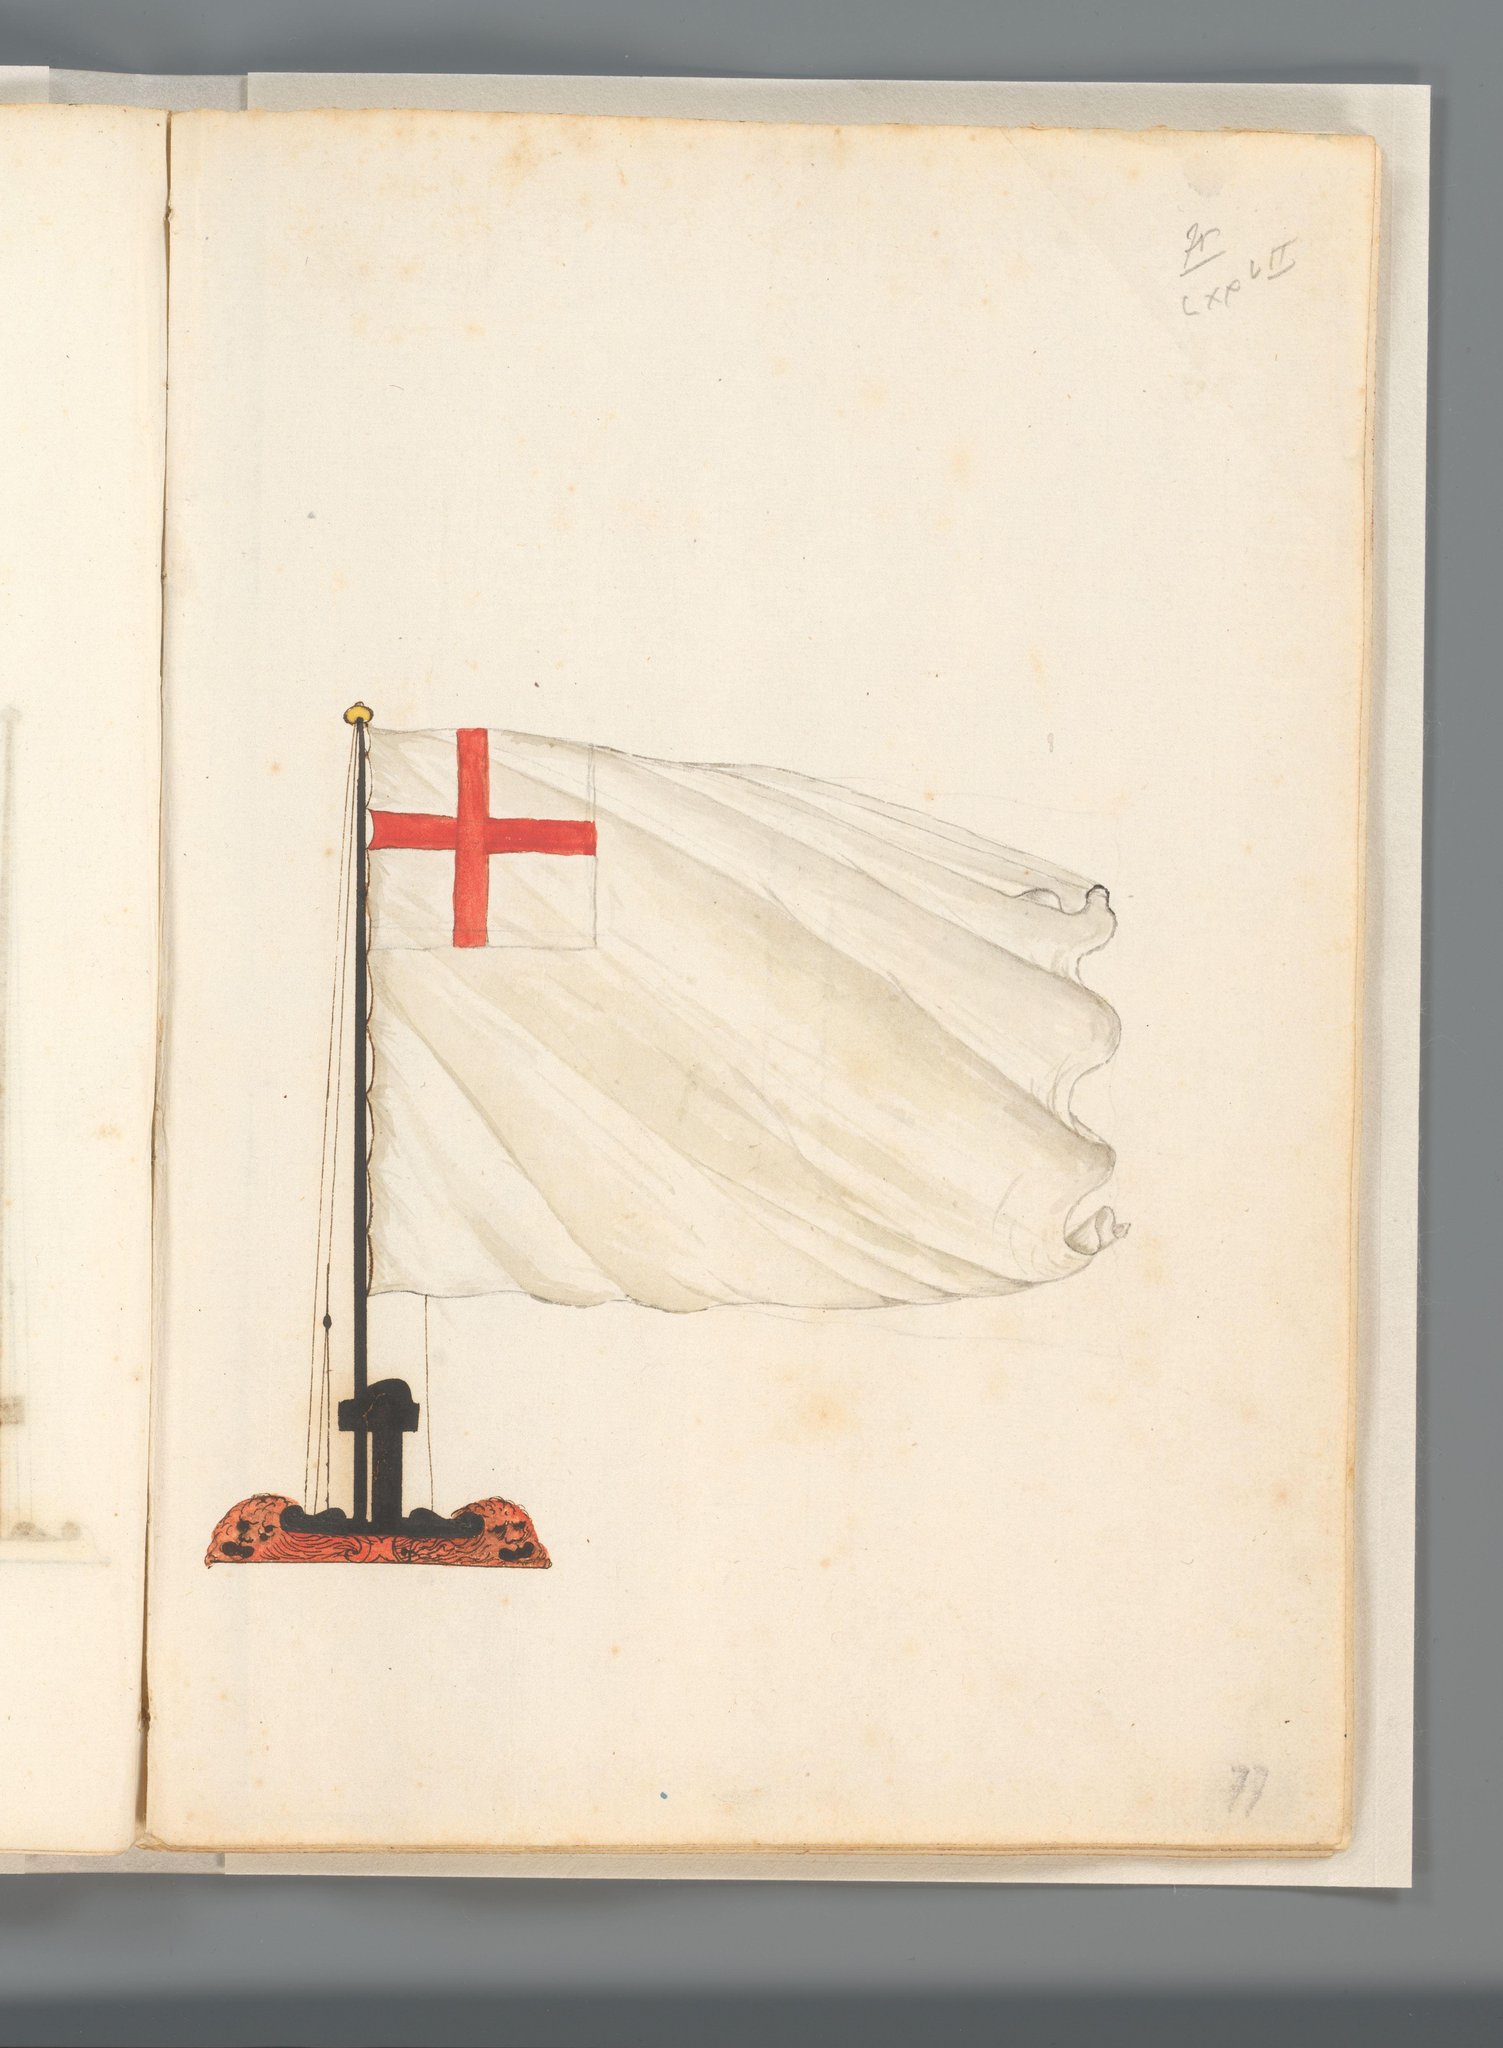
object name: drawing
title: Vlag van Groot-Brittannië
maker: Anonymous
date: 1667-1670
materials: ink, paper, watercolor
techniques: brush, pen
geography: france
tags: flag, colours (as symbol of the state, etc.), great britain, england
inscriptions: number: ‘75 / LXXVII / 77’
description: Vlag van Groot-Brittannië. Witte vlag met in de linker bovenhoek het kruis van Sint-Joris (Saint George's Cross), de Engelse vlag. Vlag op vlaggensteng en mastvoet. Afgebeeld op folio 39r. Onderdeel van een vlaggenboek met vlaggen uit Europa, Noord-Afrika, Nabije en Verre Oosten.